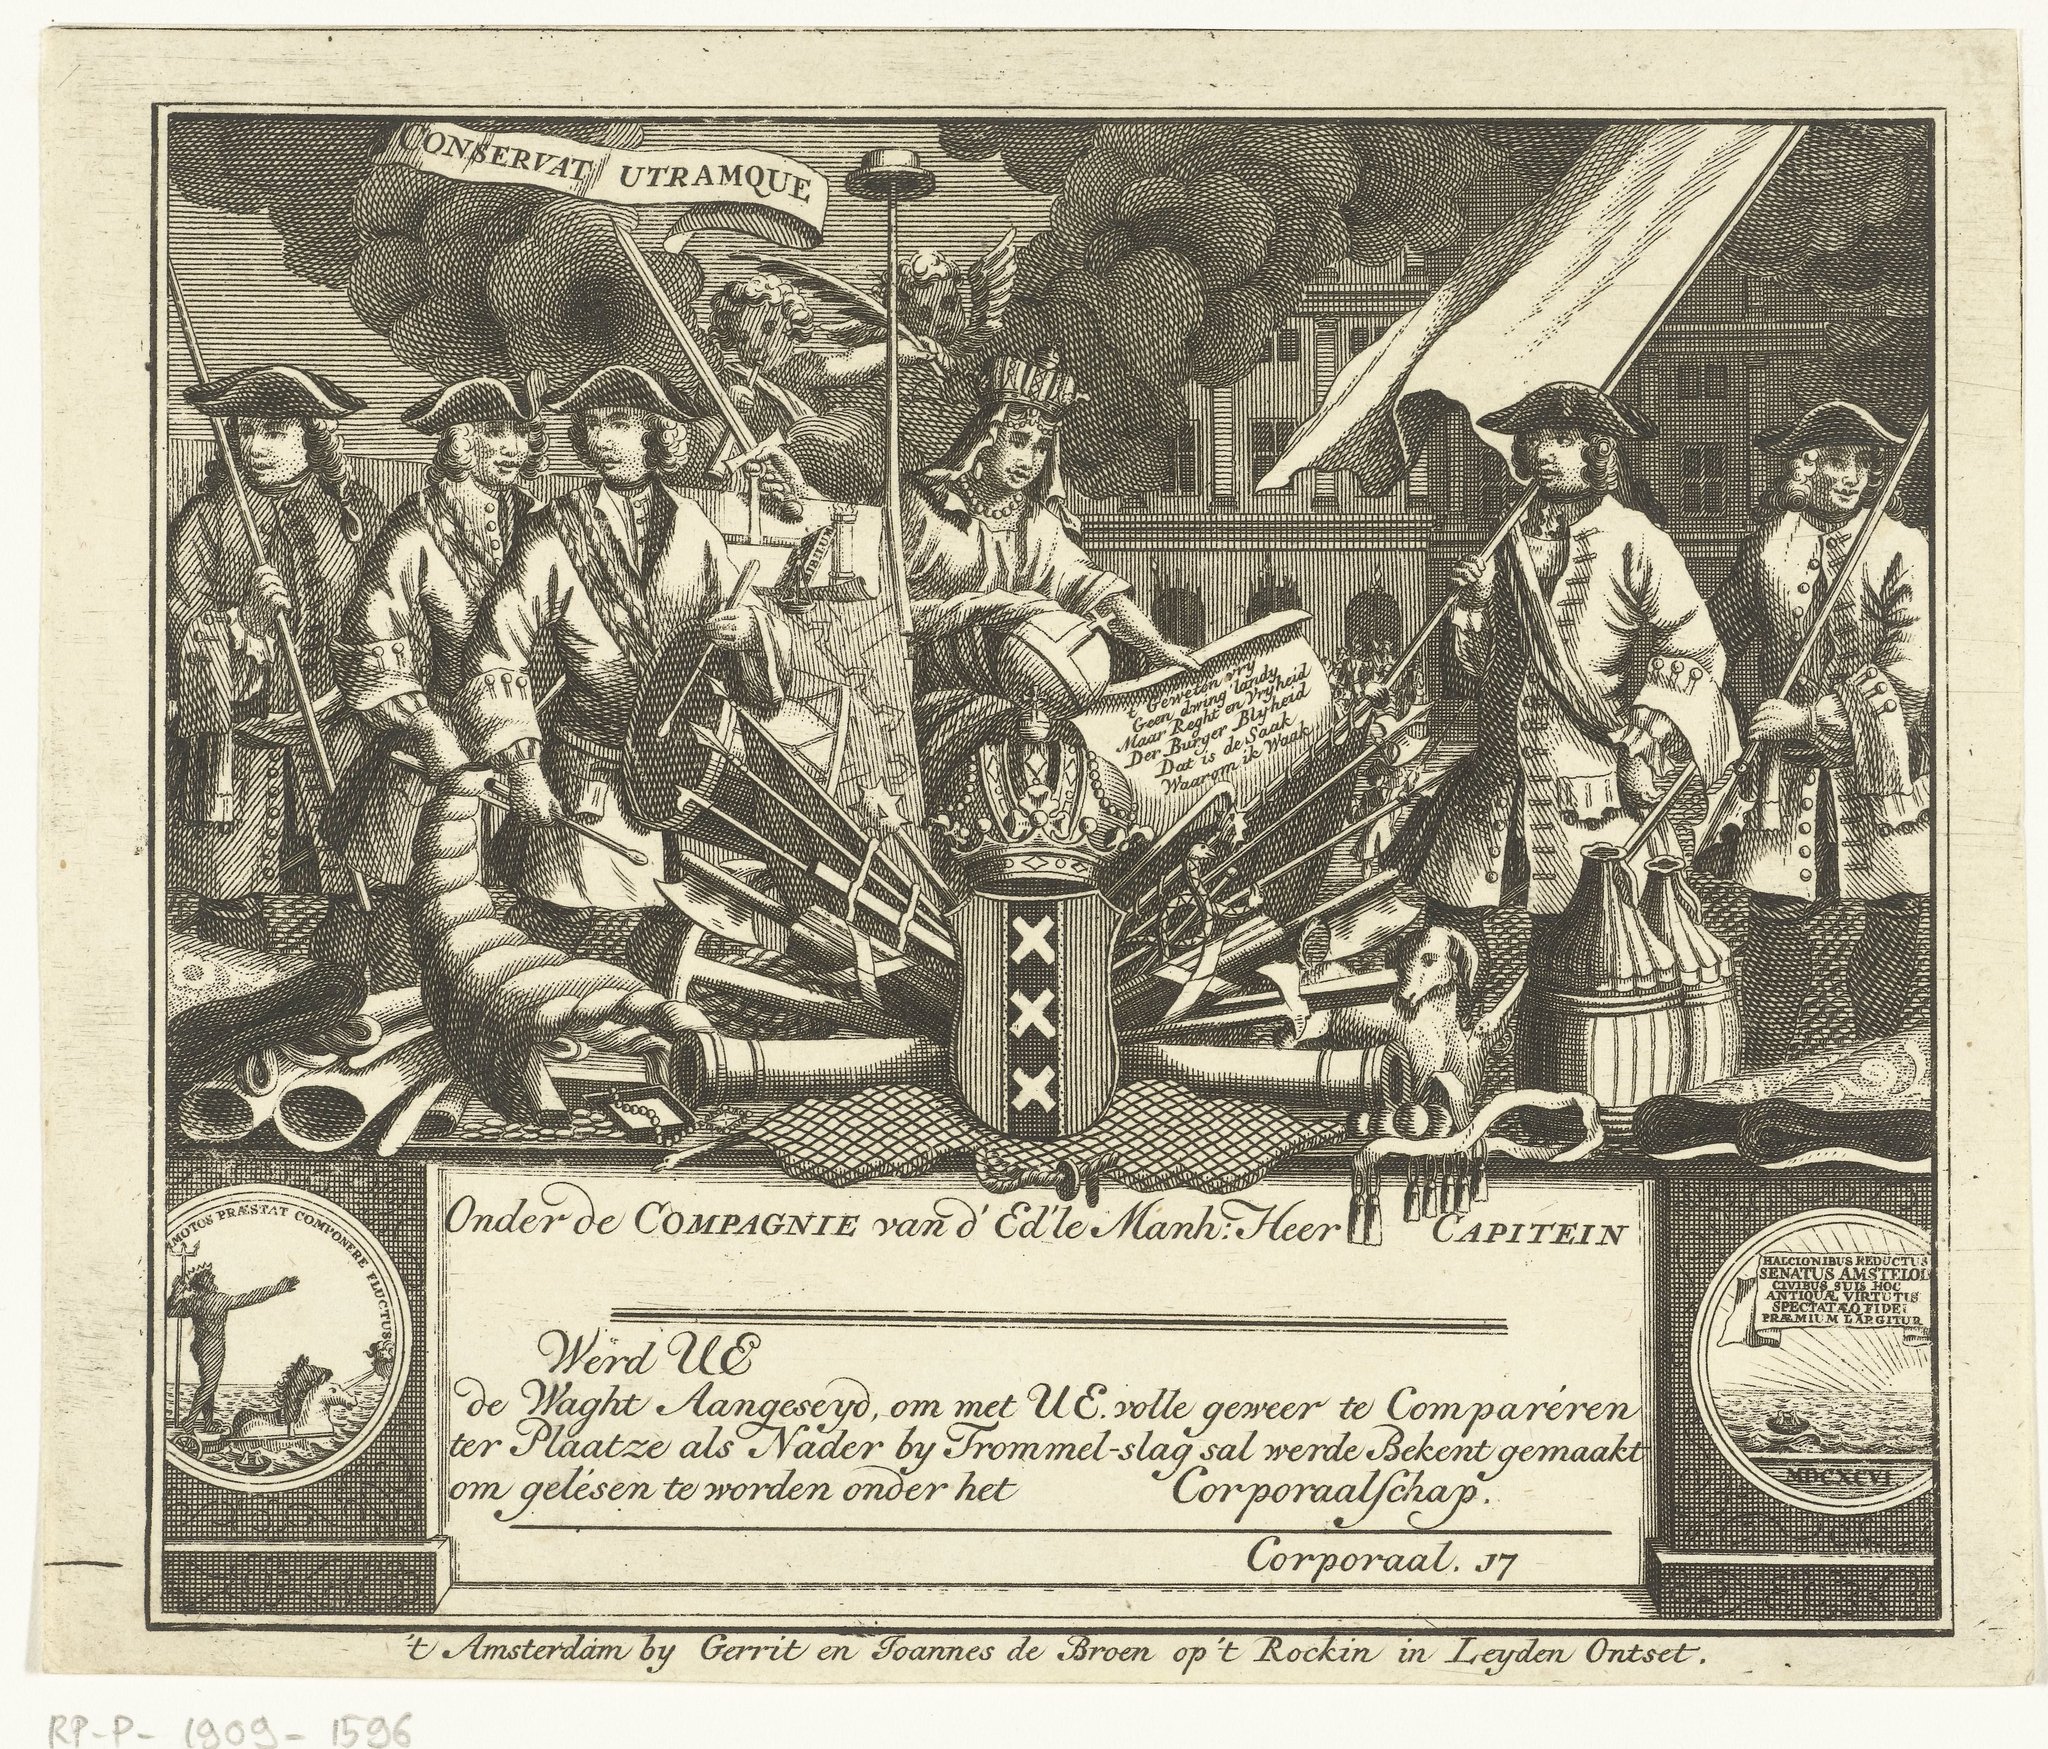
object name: print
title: Schuttersbrief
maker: gerrit de broen (ii)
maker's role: print maker, publisher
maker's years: 1692-1774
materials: paper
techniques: etching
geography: amsterdam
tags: personification of a city, town-patron(ess), guard duty, keeping sentry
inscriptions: collector's mark: Lugt 2228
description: De Amsterdamse stedenmaagd staand tussen vijf schutters. In het midden het wapen van Amsterdam en verschillend wapentuig. Onder het wapen een oproep voor het betrekken der wacht met een nog niet ingevuld veld voor de naam van de betreffende schutter. Aan weerszijden van de tekst de twee kanten van een penning te ere van de demping van het Aansprekeroproer van 1696, gemaakt door de raad van de stad.